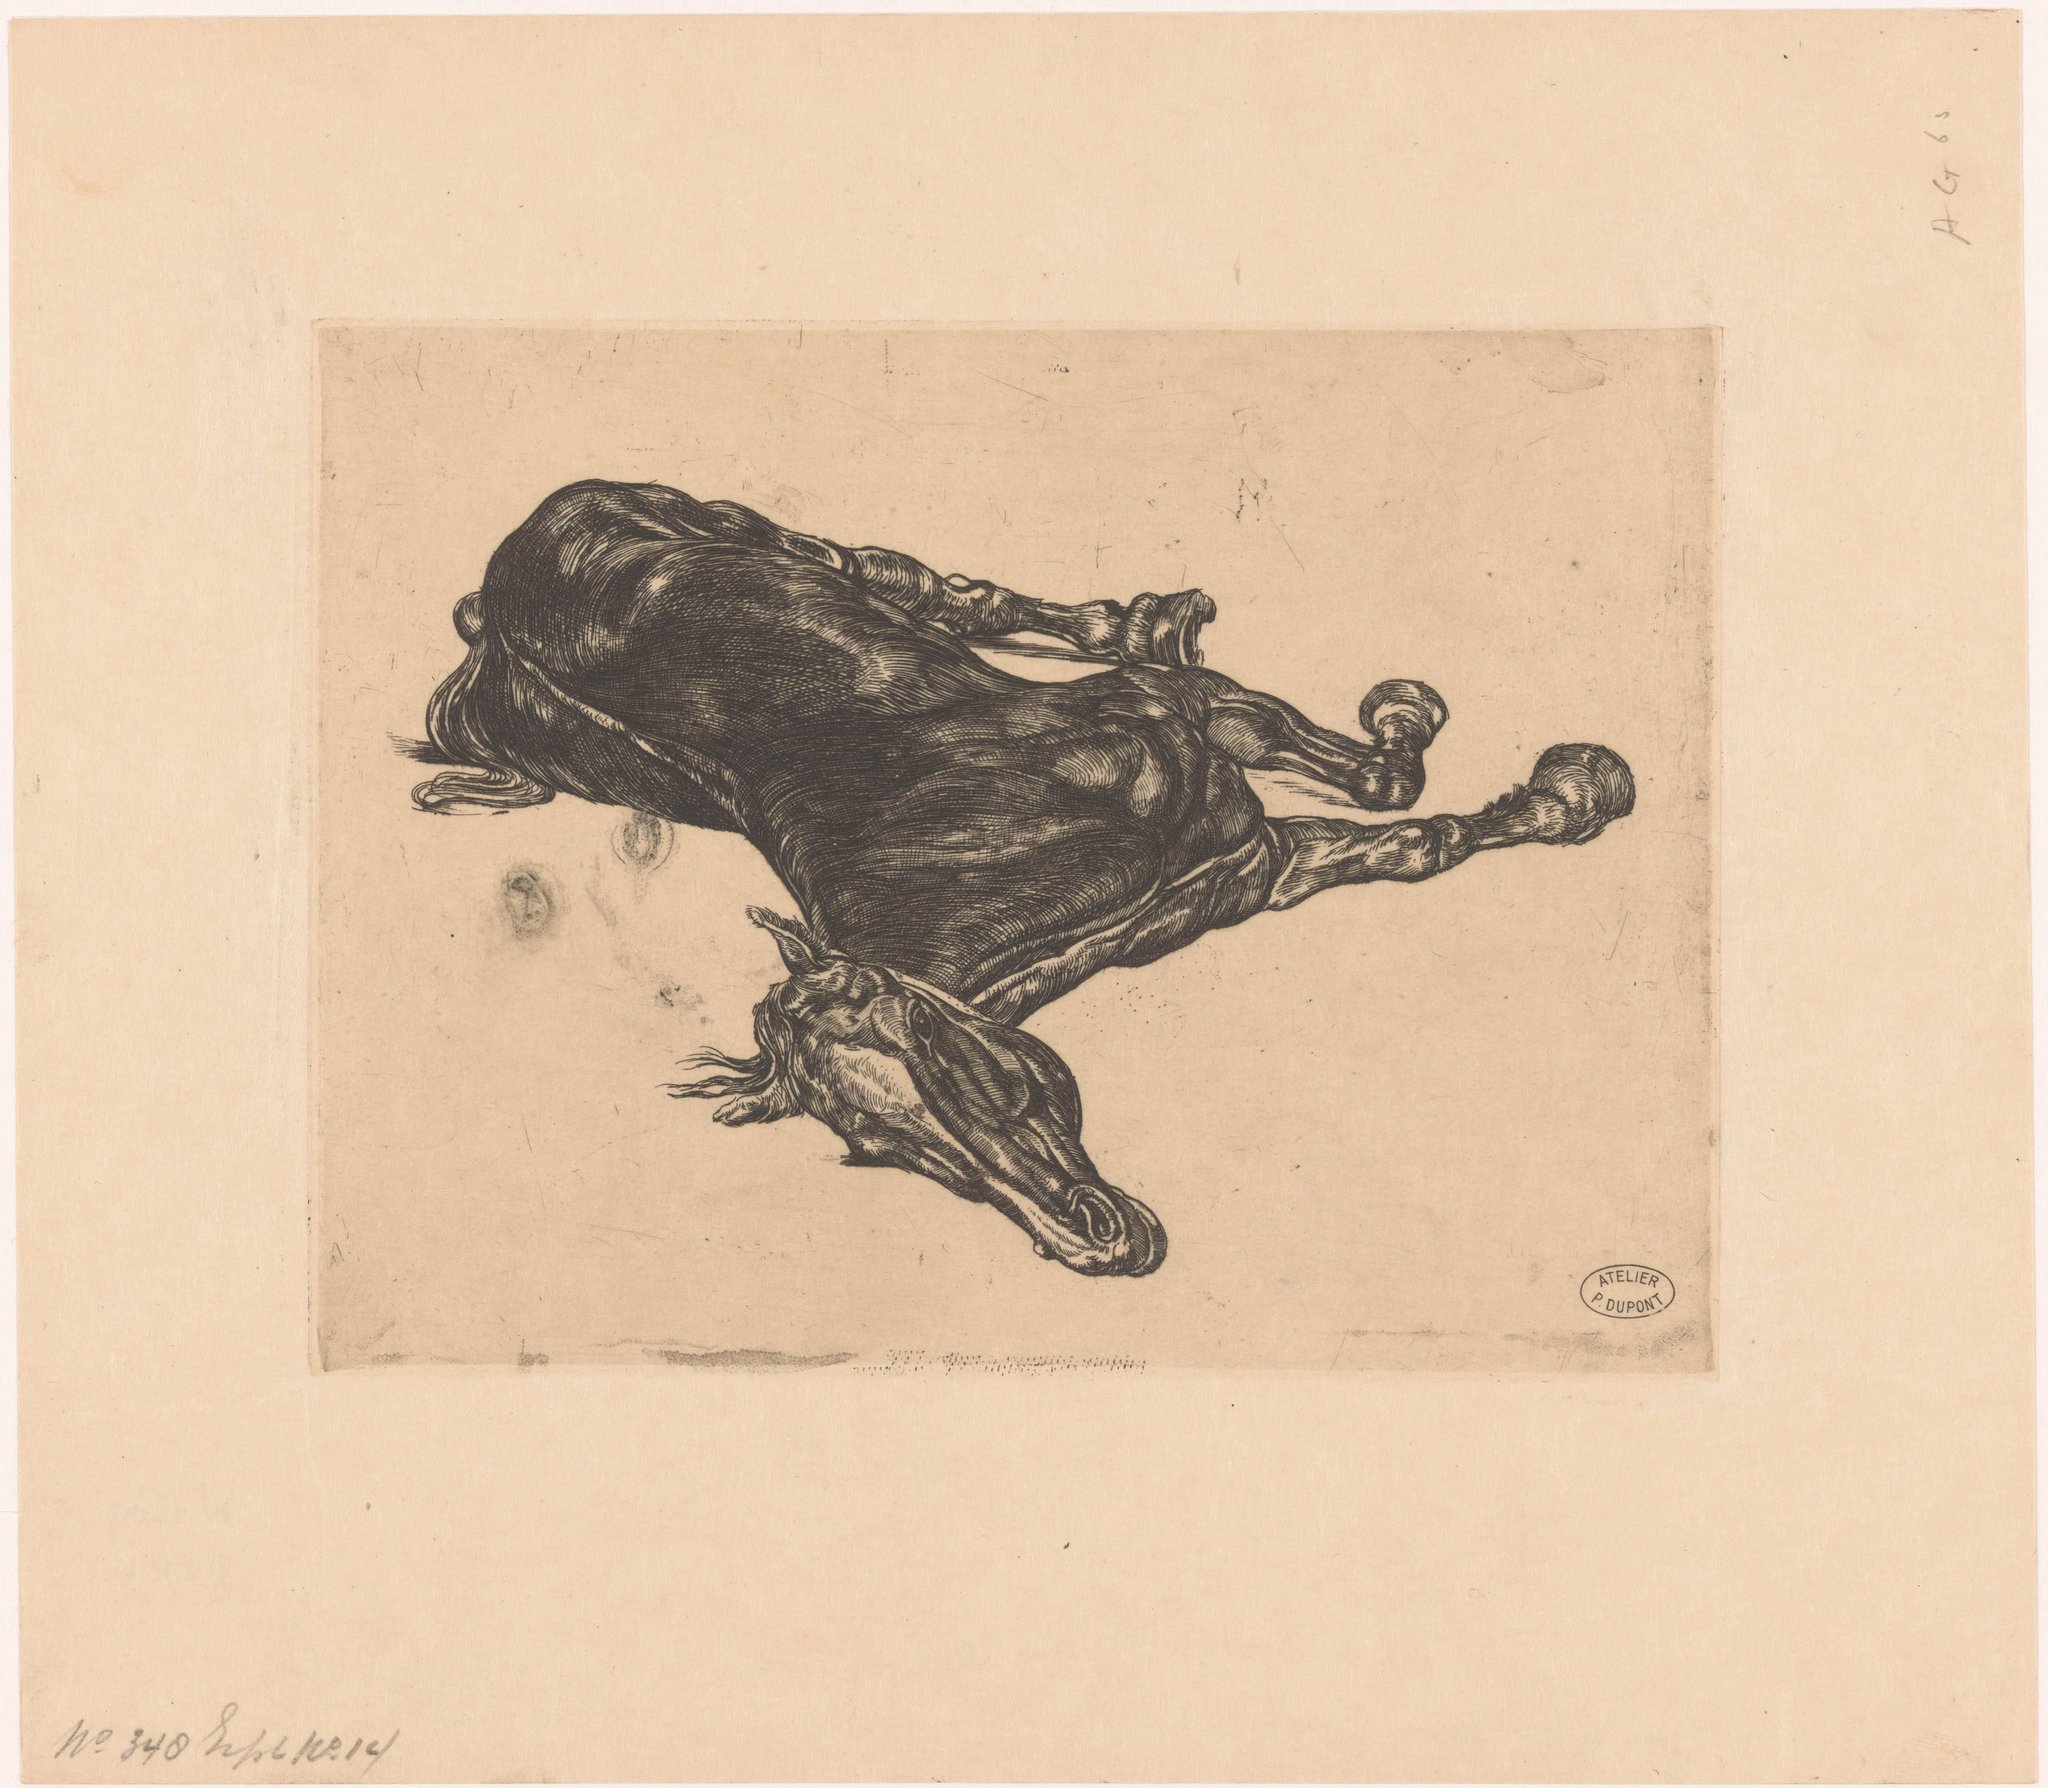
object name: print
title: Dood paard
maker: pieter dupont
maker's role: draughtsman, print maker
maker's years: 1870-1911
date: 1900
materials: paper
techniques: etching, intaglio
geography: paris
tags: horses and kindred animals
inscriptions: workshop stamp: ‘ATELIER P. DUPONT’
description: Deze ets is ontstaan toen Pieter Dupont in Parijs verbleef en daar in een abattoir studies maakte.